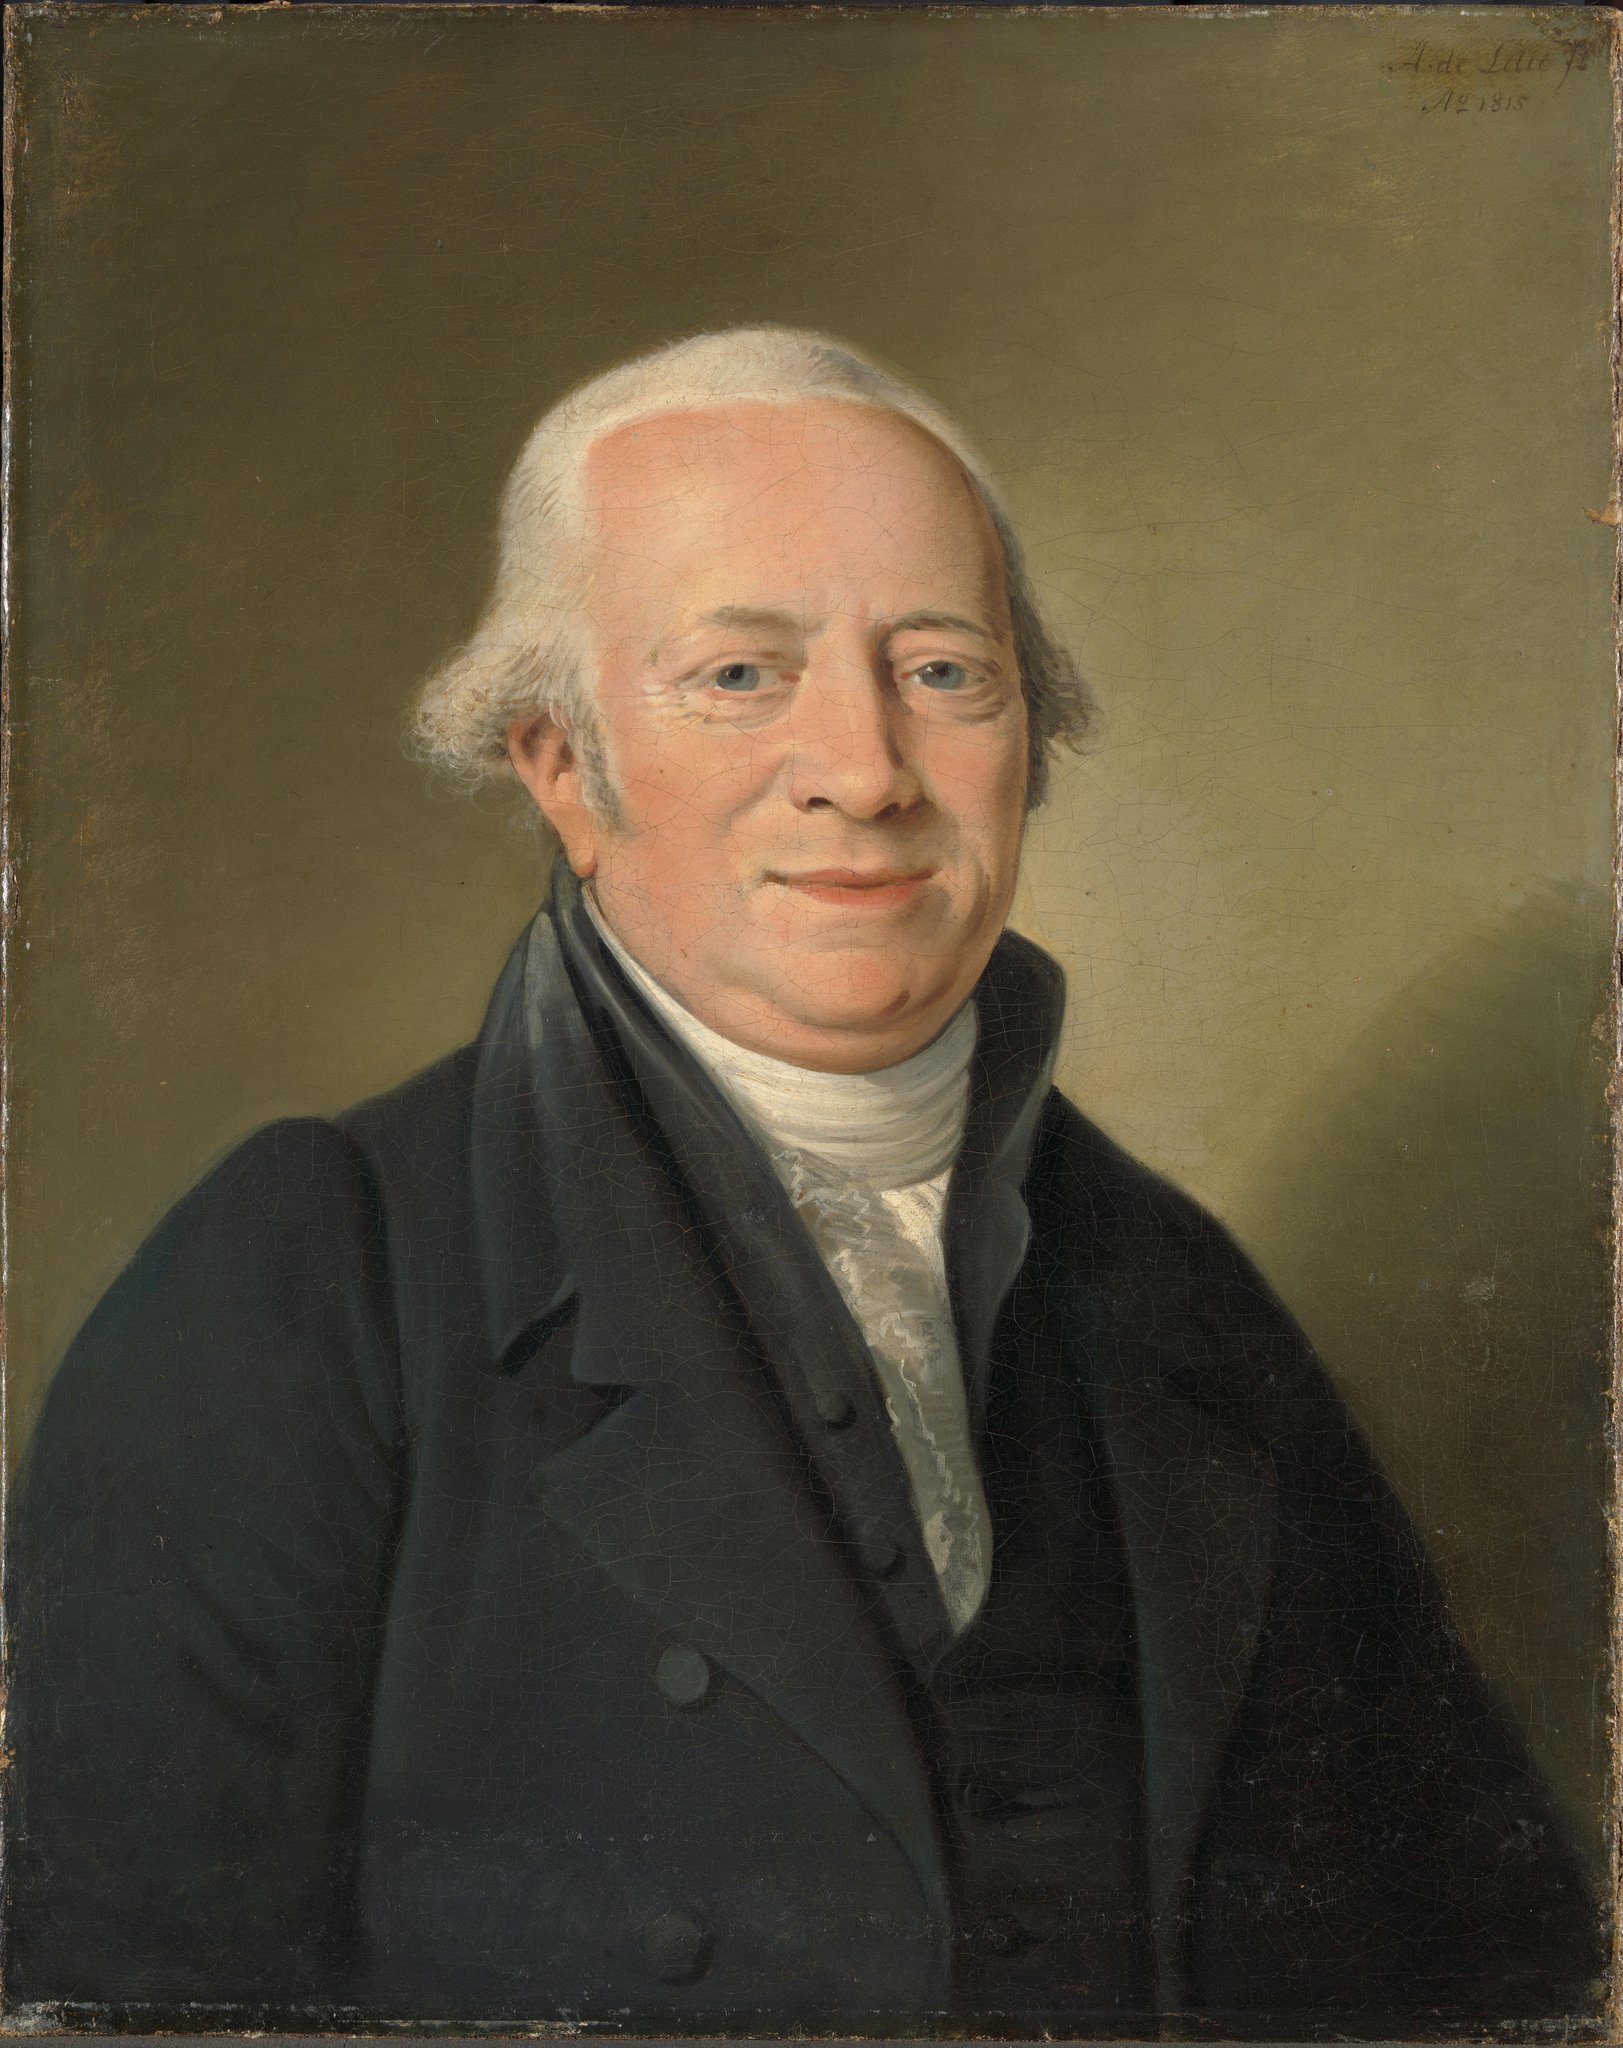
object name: painting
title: Cornelis Sebille Roos (1754-1820), Amsterdam Art Dealer and Keeper of the Nationale Konst-Gallery in Huis ten Bosch, The Hague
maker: adriaan de lelie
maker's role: draughtsman, painter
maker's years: 1755-1820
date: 1815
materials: canvas, oil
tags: amsterdam, auctioneer, draughtsman, publisher, cornelis sebille roos (uitgever), historical persons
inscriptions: signature and date: ‘A. de Lelie ft. Aº1815’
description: Cornelis Sebille Roos, by A. de Lelie, 1815. Cornelis Roos (1754-1820) was the first director of the Nationale Konstgallerij - the national artgallery - which opened to the public in 1800. This museum, the forerunner of today's Rijksmuseum, was housed in Huis ten Bosch in The Hague. It included paintings and objects from the collections assembled by successive stadholders.